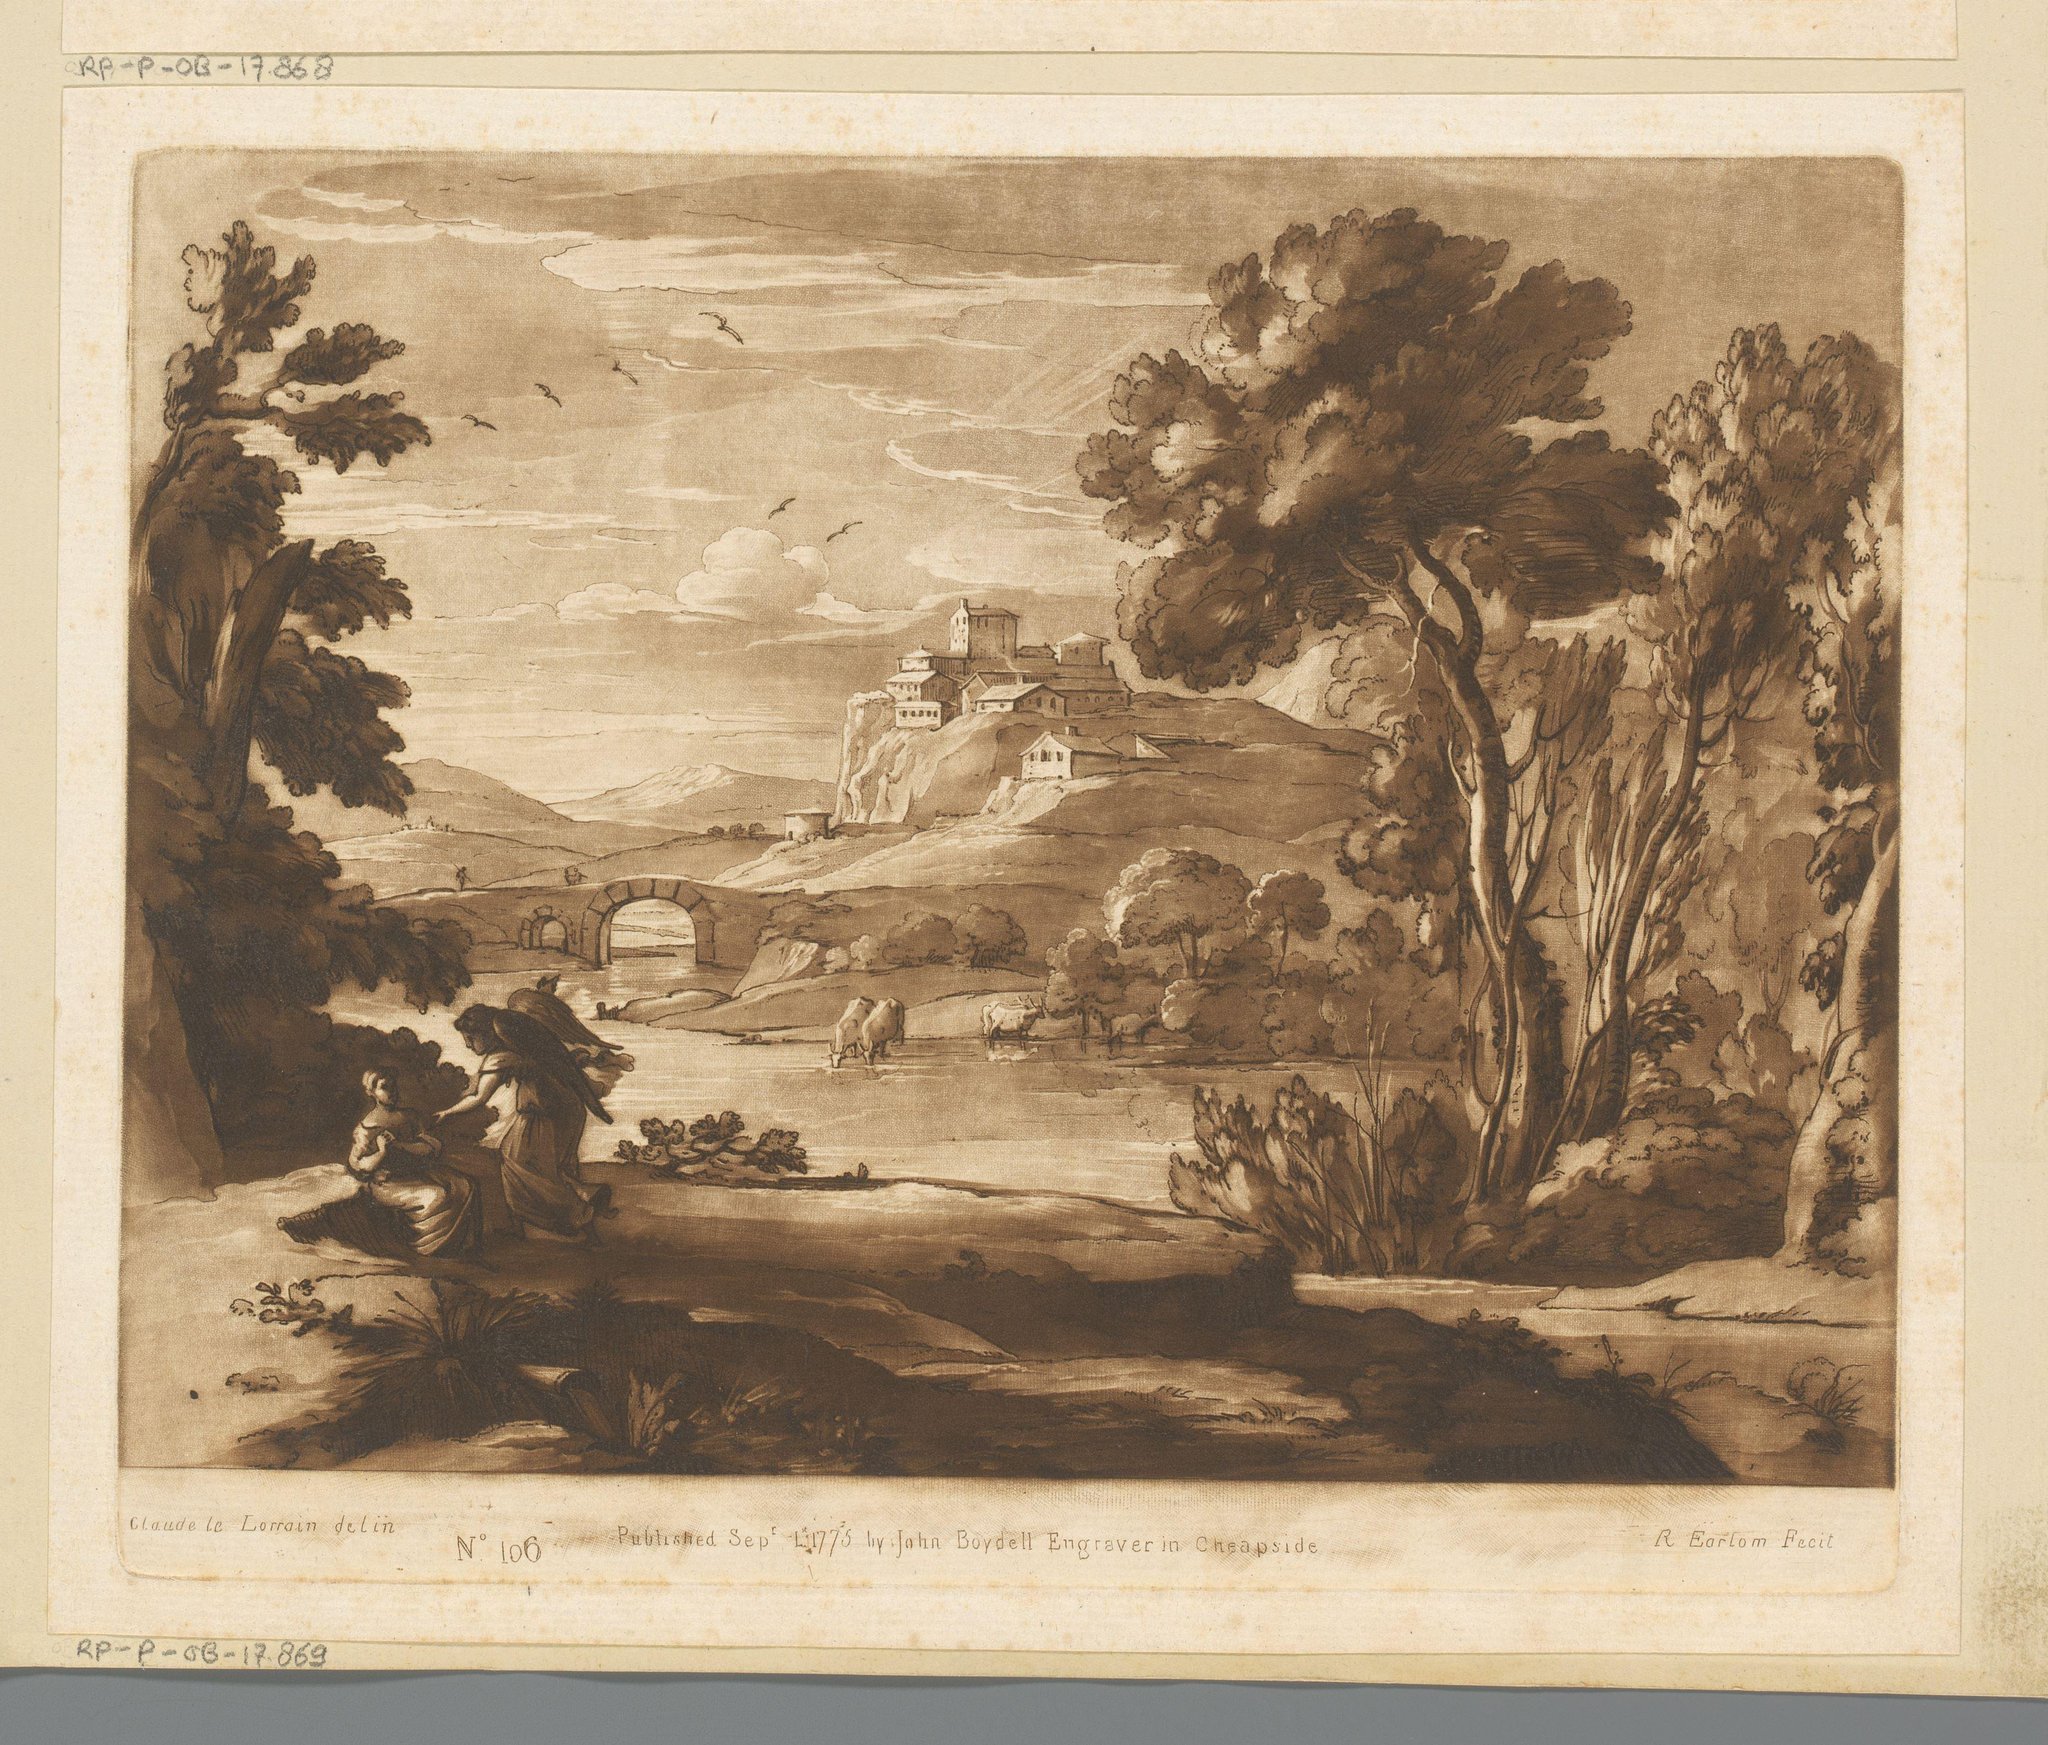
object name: print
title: Liber Veritatis. Or a Collection of Two Hundred Prints, after the original designs of Claude le Lorrain (...)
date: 1775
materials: paper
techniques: etching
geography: london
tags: an angel meets hagar at the fountain on the way to shur and persuades her to return, landscape with bridge, viaduct or aqueduct - ii - ideal landscapes, lake - hh - ideal landscapes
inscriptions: date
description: Vanaf 1774 publiceerde John Boydell tweehonderd prenten naar het tekeningenboek Liber Veritatis van Claude Lorrain, in het bezit van de hertogen van Cavendish. Deze prenten werden vanaf 1777 in twee volumes gebundeld uitgegeven.